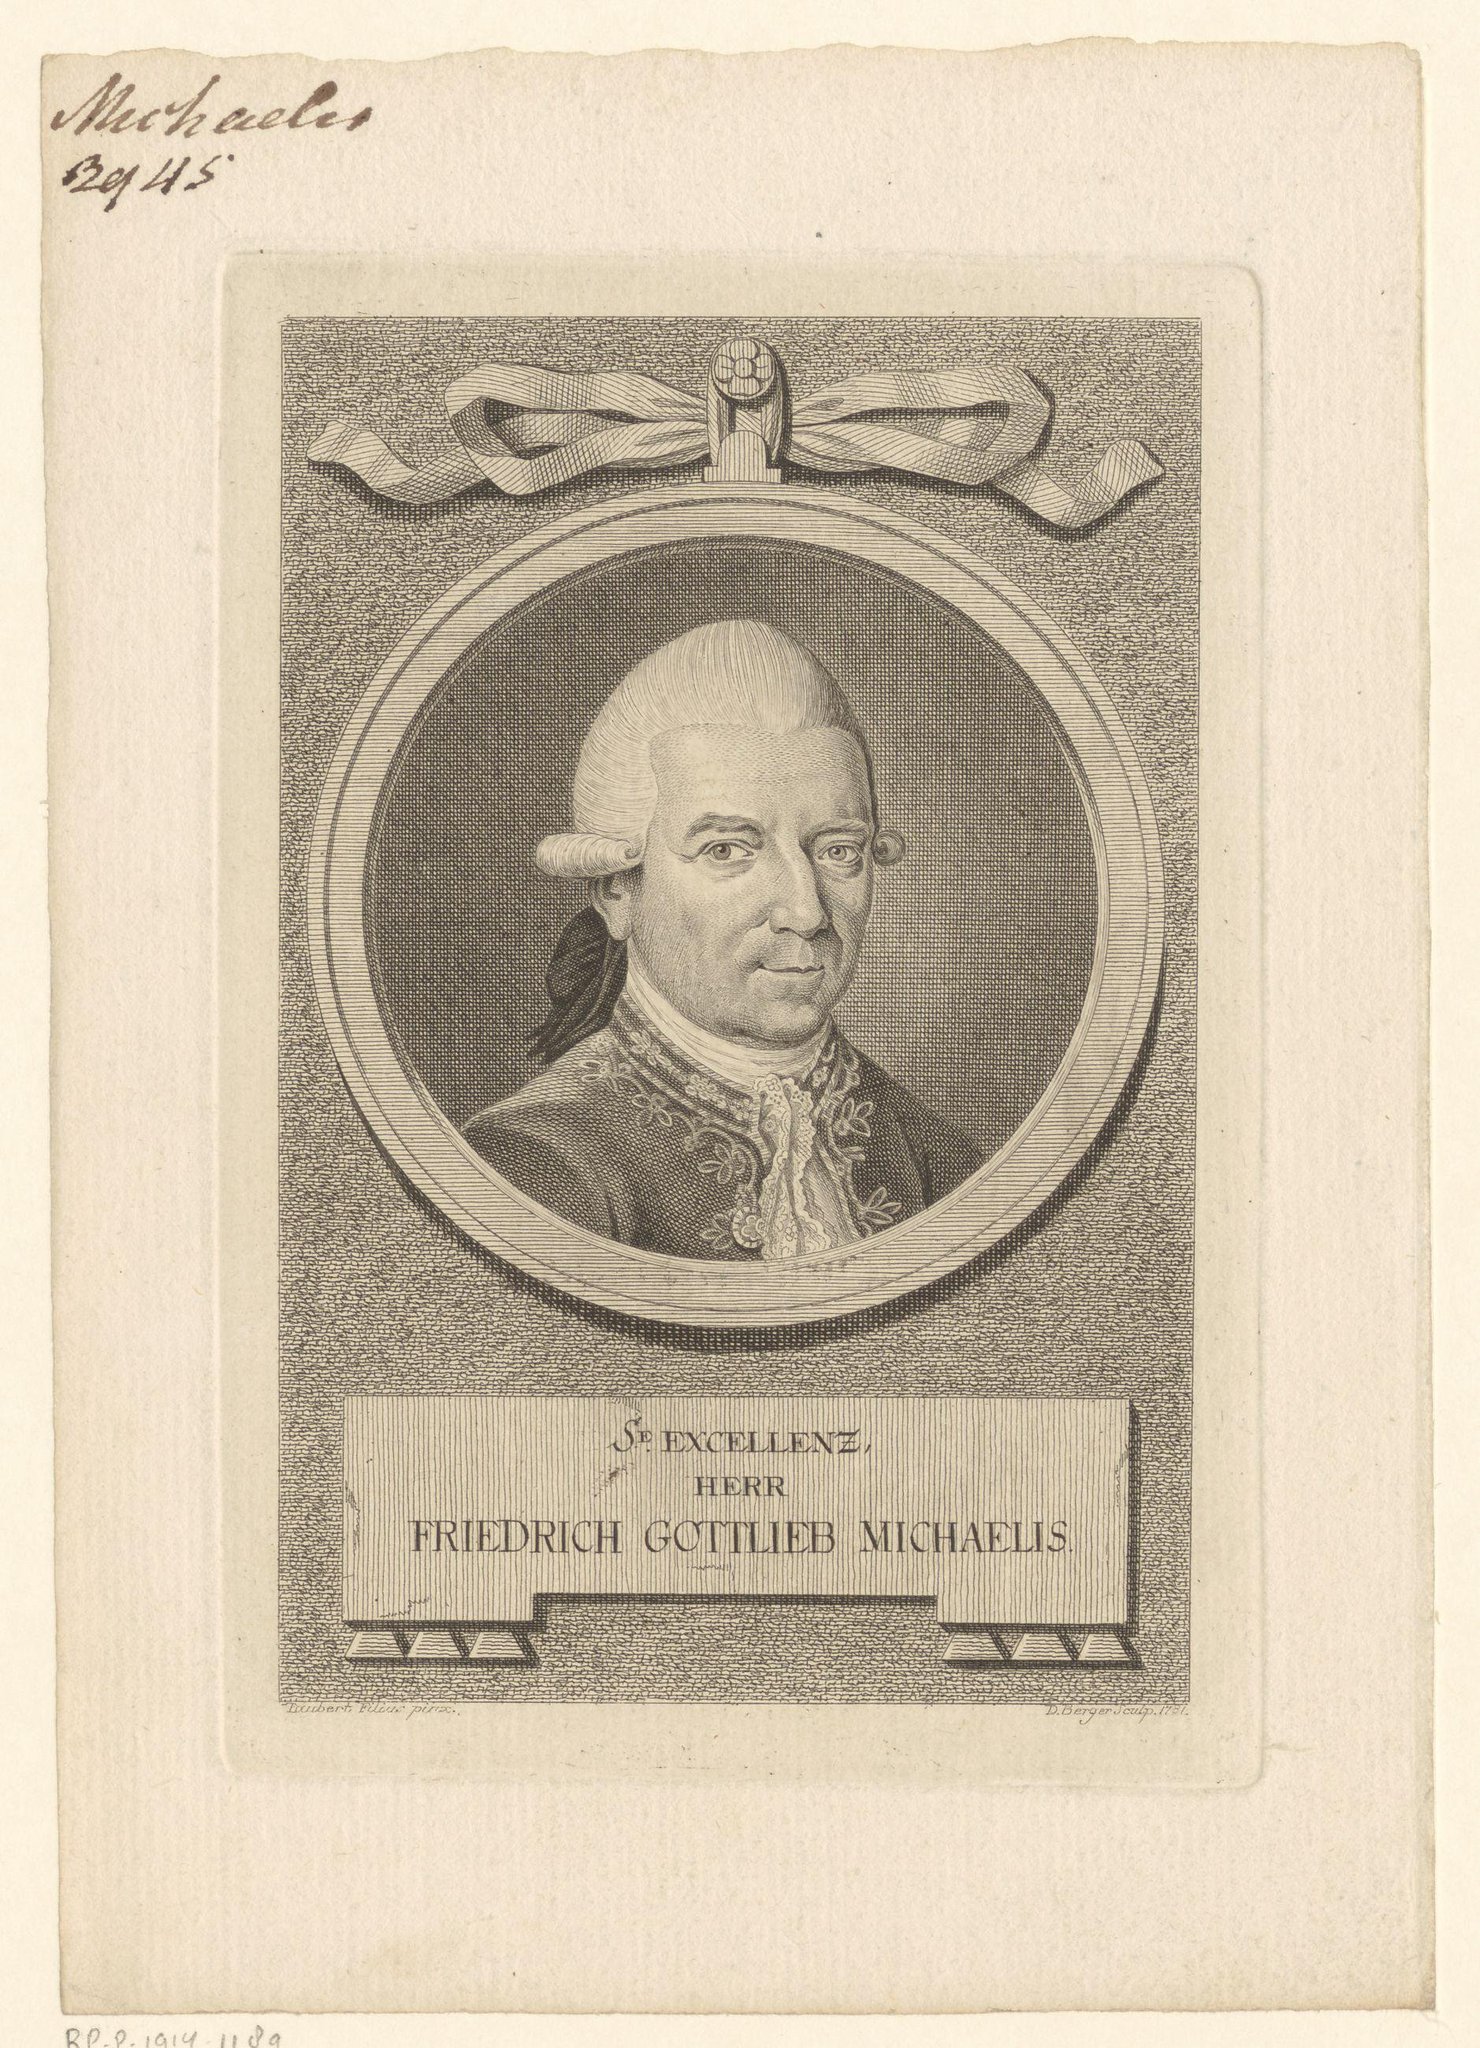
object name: print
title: Portret van Friedrich Gottlieb Michaelis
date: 1781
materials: paper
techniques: engraving, etching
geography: berlin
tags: historical persons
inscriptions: collector's mark: Lugt 2228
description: Prent ook gebruikt in: Krünitz, Johann Georg. Oeconomische Encyclopädie. dl. 21. Berlijn: Joachim Pauli, 1780.